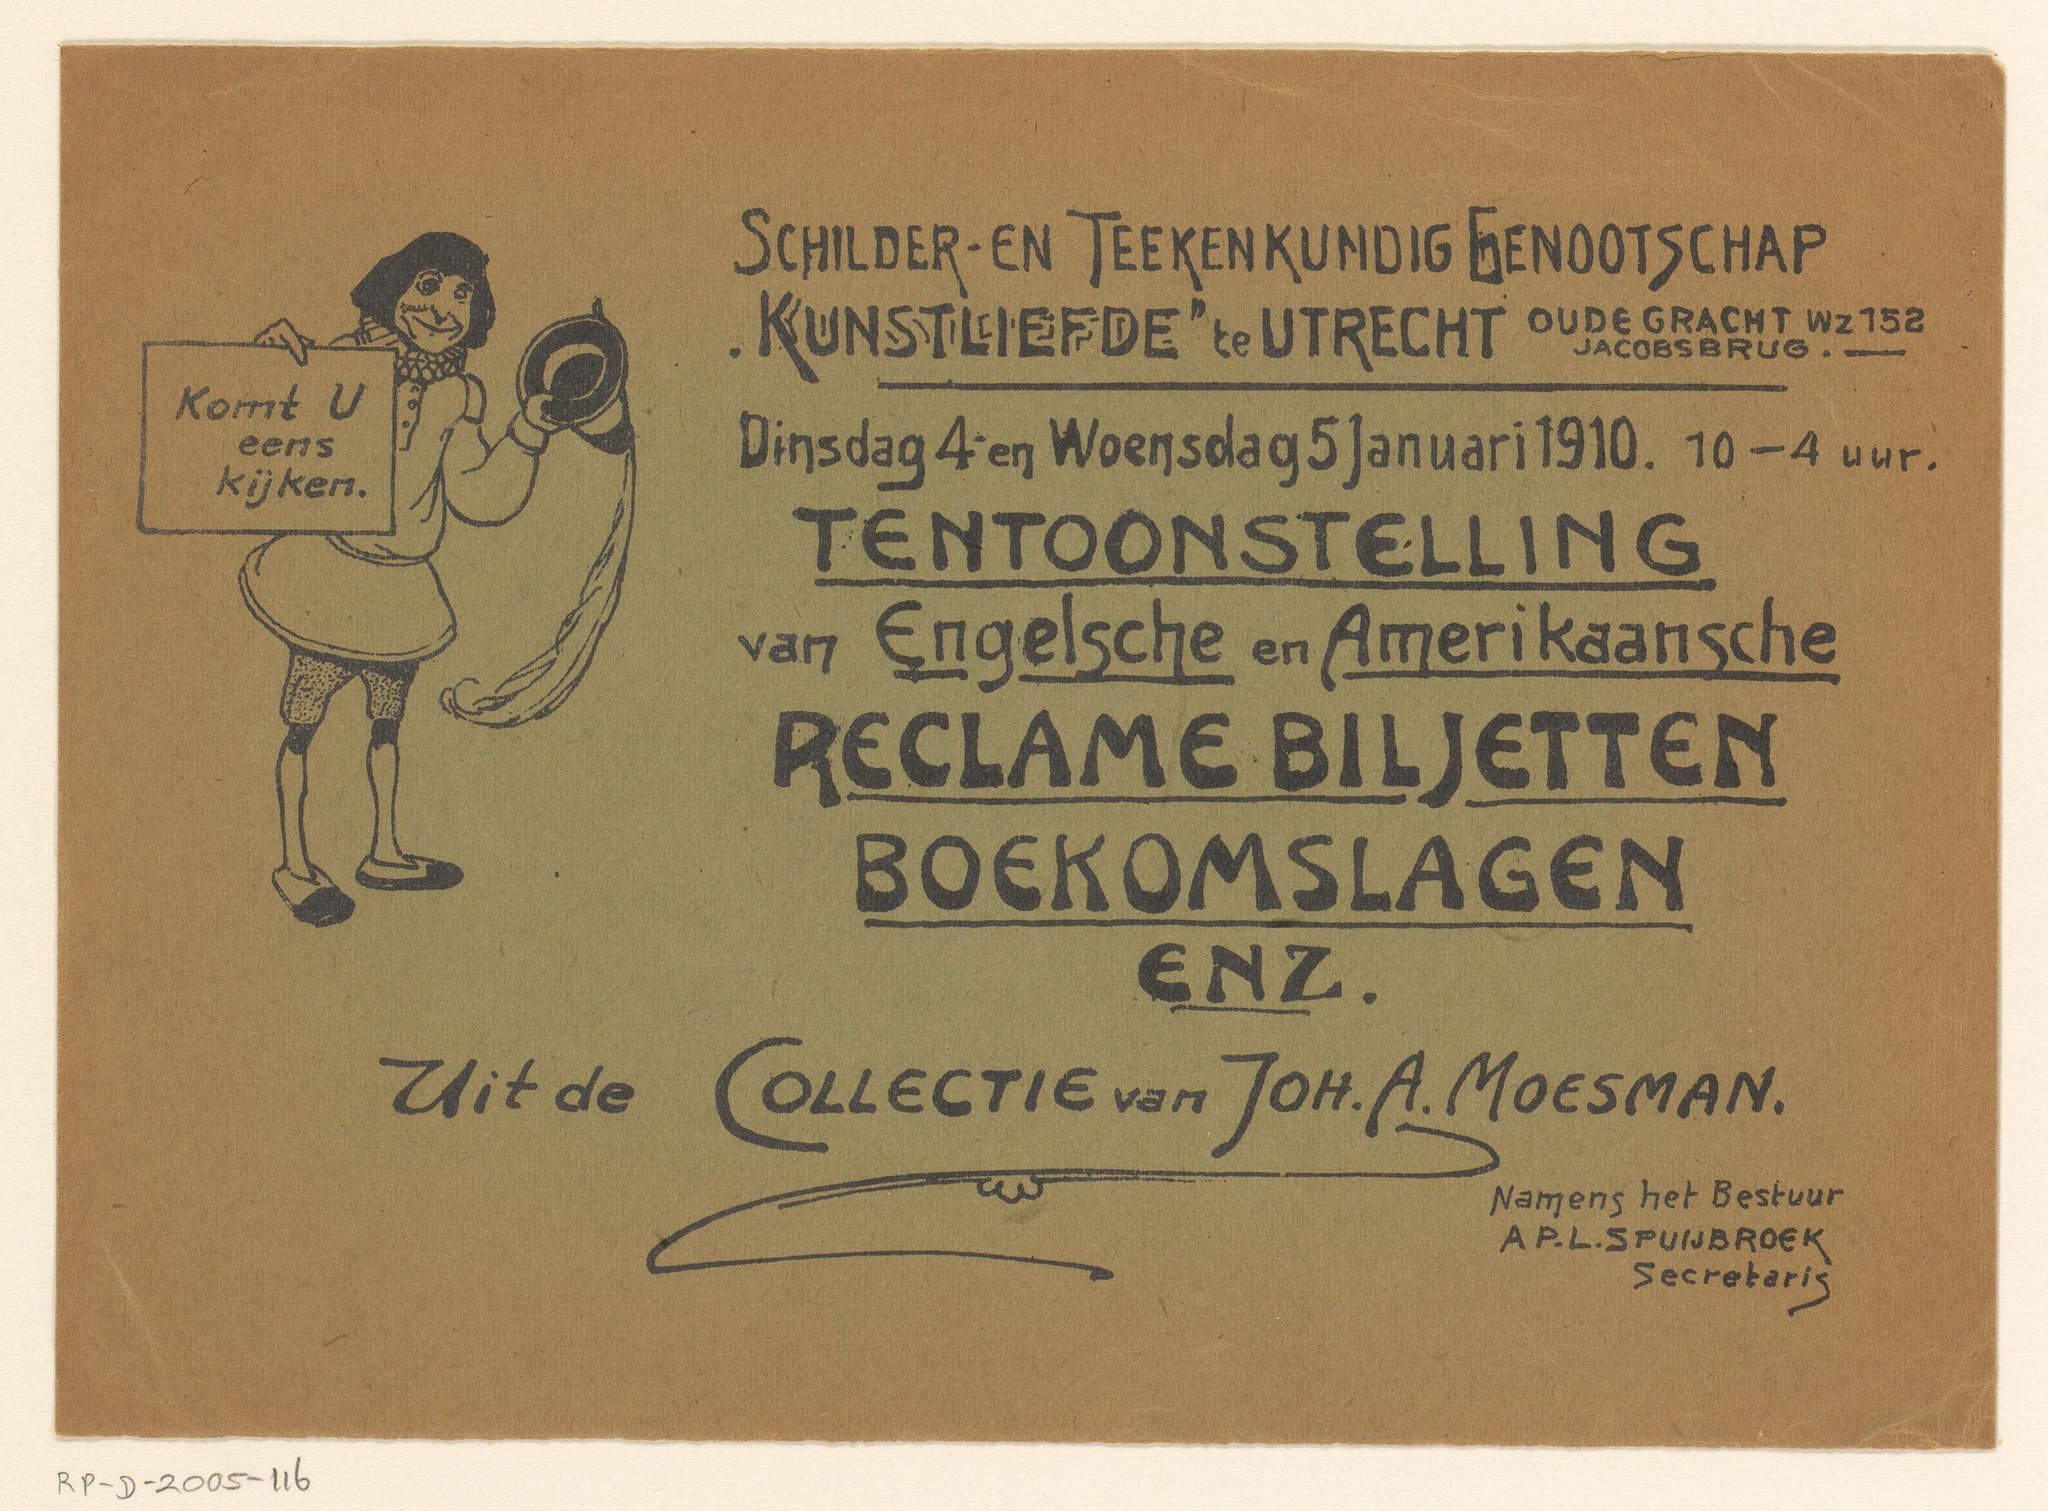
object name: invitation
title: Uitnodiging van Schilder- en Teekenkundig Genootschap "Kunstliefde" voor een tentoonstelling van Engelse en Amerikaanse reclamebiljetten en boekomslagen, 4-5 januari 1910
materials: paper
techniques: lithograph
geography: netherlands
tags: criticizing and discussing art, art criticism, circle, club of artists, collecting and exhibiting products of the fine arts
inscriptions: collector's mark: Lugt 2228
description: Staande popfiguur met uitnodiging in de hand. Uitnodiging van Schilder- en Teekenkundig Genootschap "Kunstliefde" voor een tentoonstelling op 4-5 januari 1910 van Engelse en Amerikaanse reclamebiljetten en boekomslagen uit de collectie van Johannes Moesman.